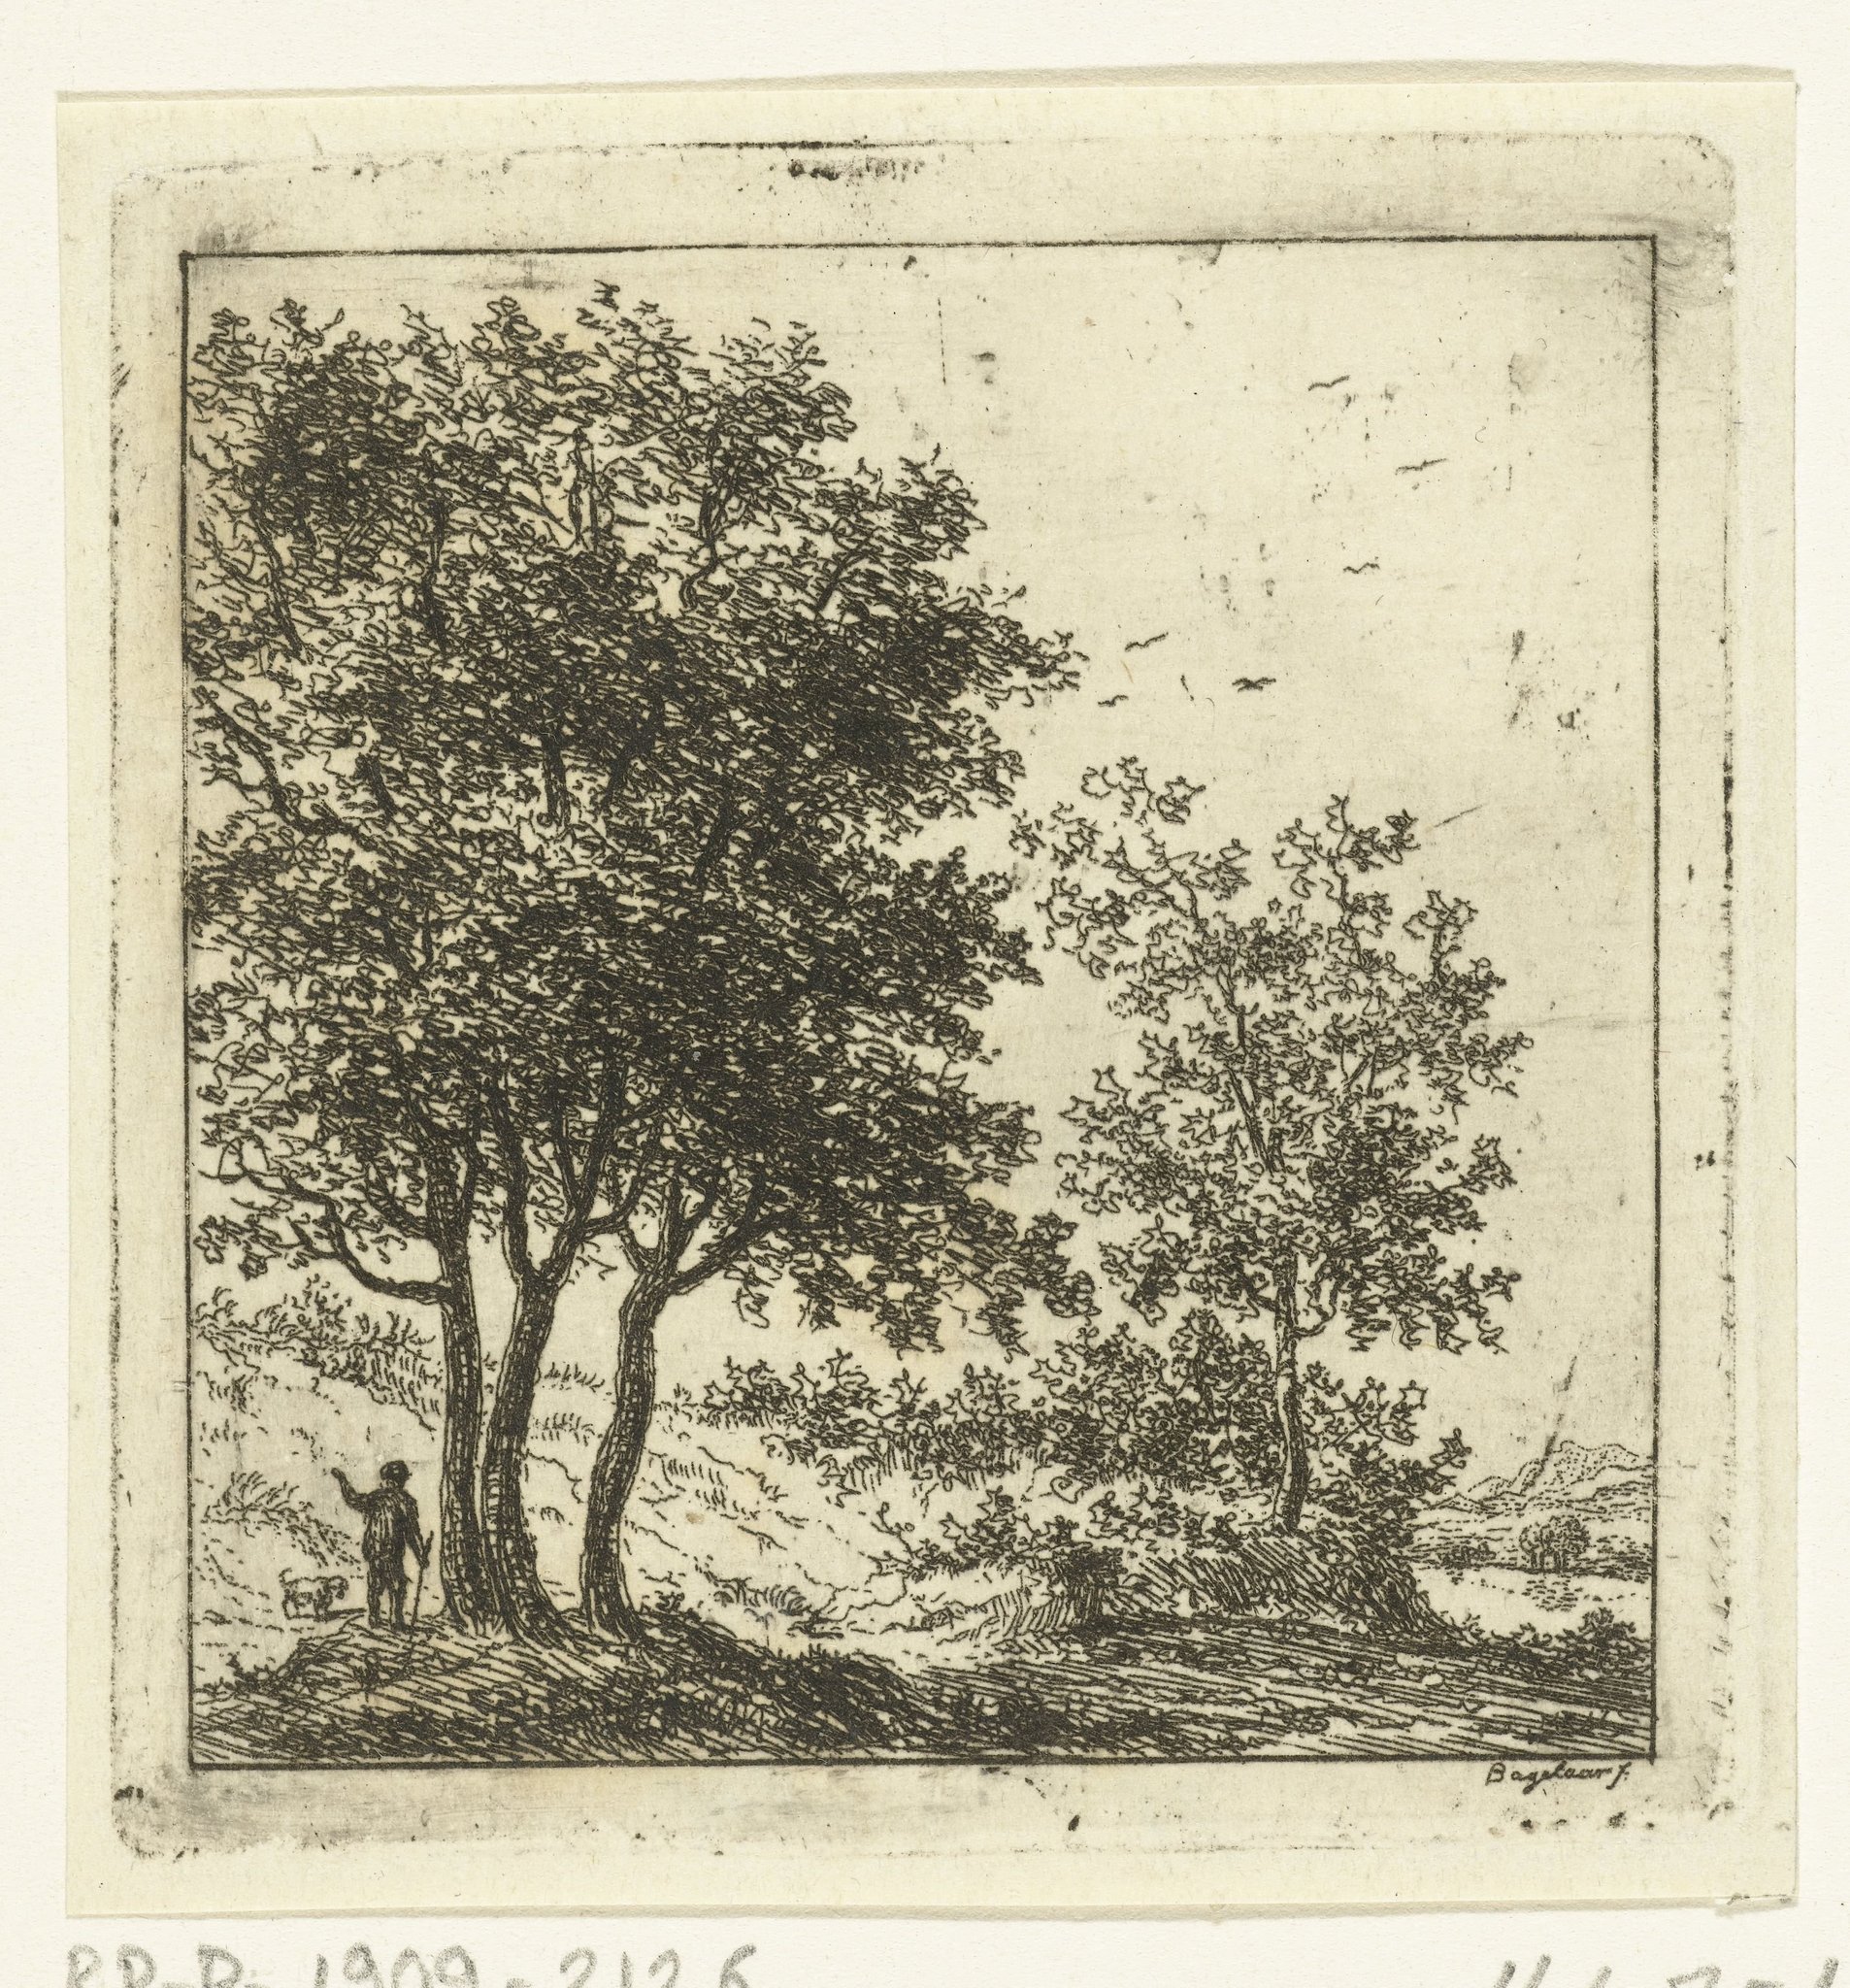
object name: print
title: Een man met hond bij een groep bomen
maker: ernst willem jan bagelaar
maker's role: draughtsman, print maker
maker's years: 1775-1837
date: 1798-1837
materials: paper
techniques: etching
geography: netherlands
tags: landscapes in the temperate zone (+ landscape with figures, staffage)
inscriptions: collector's mark: Lugt 2228